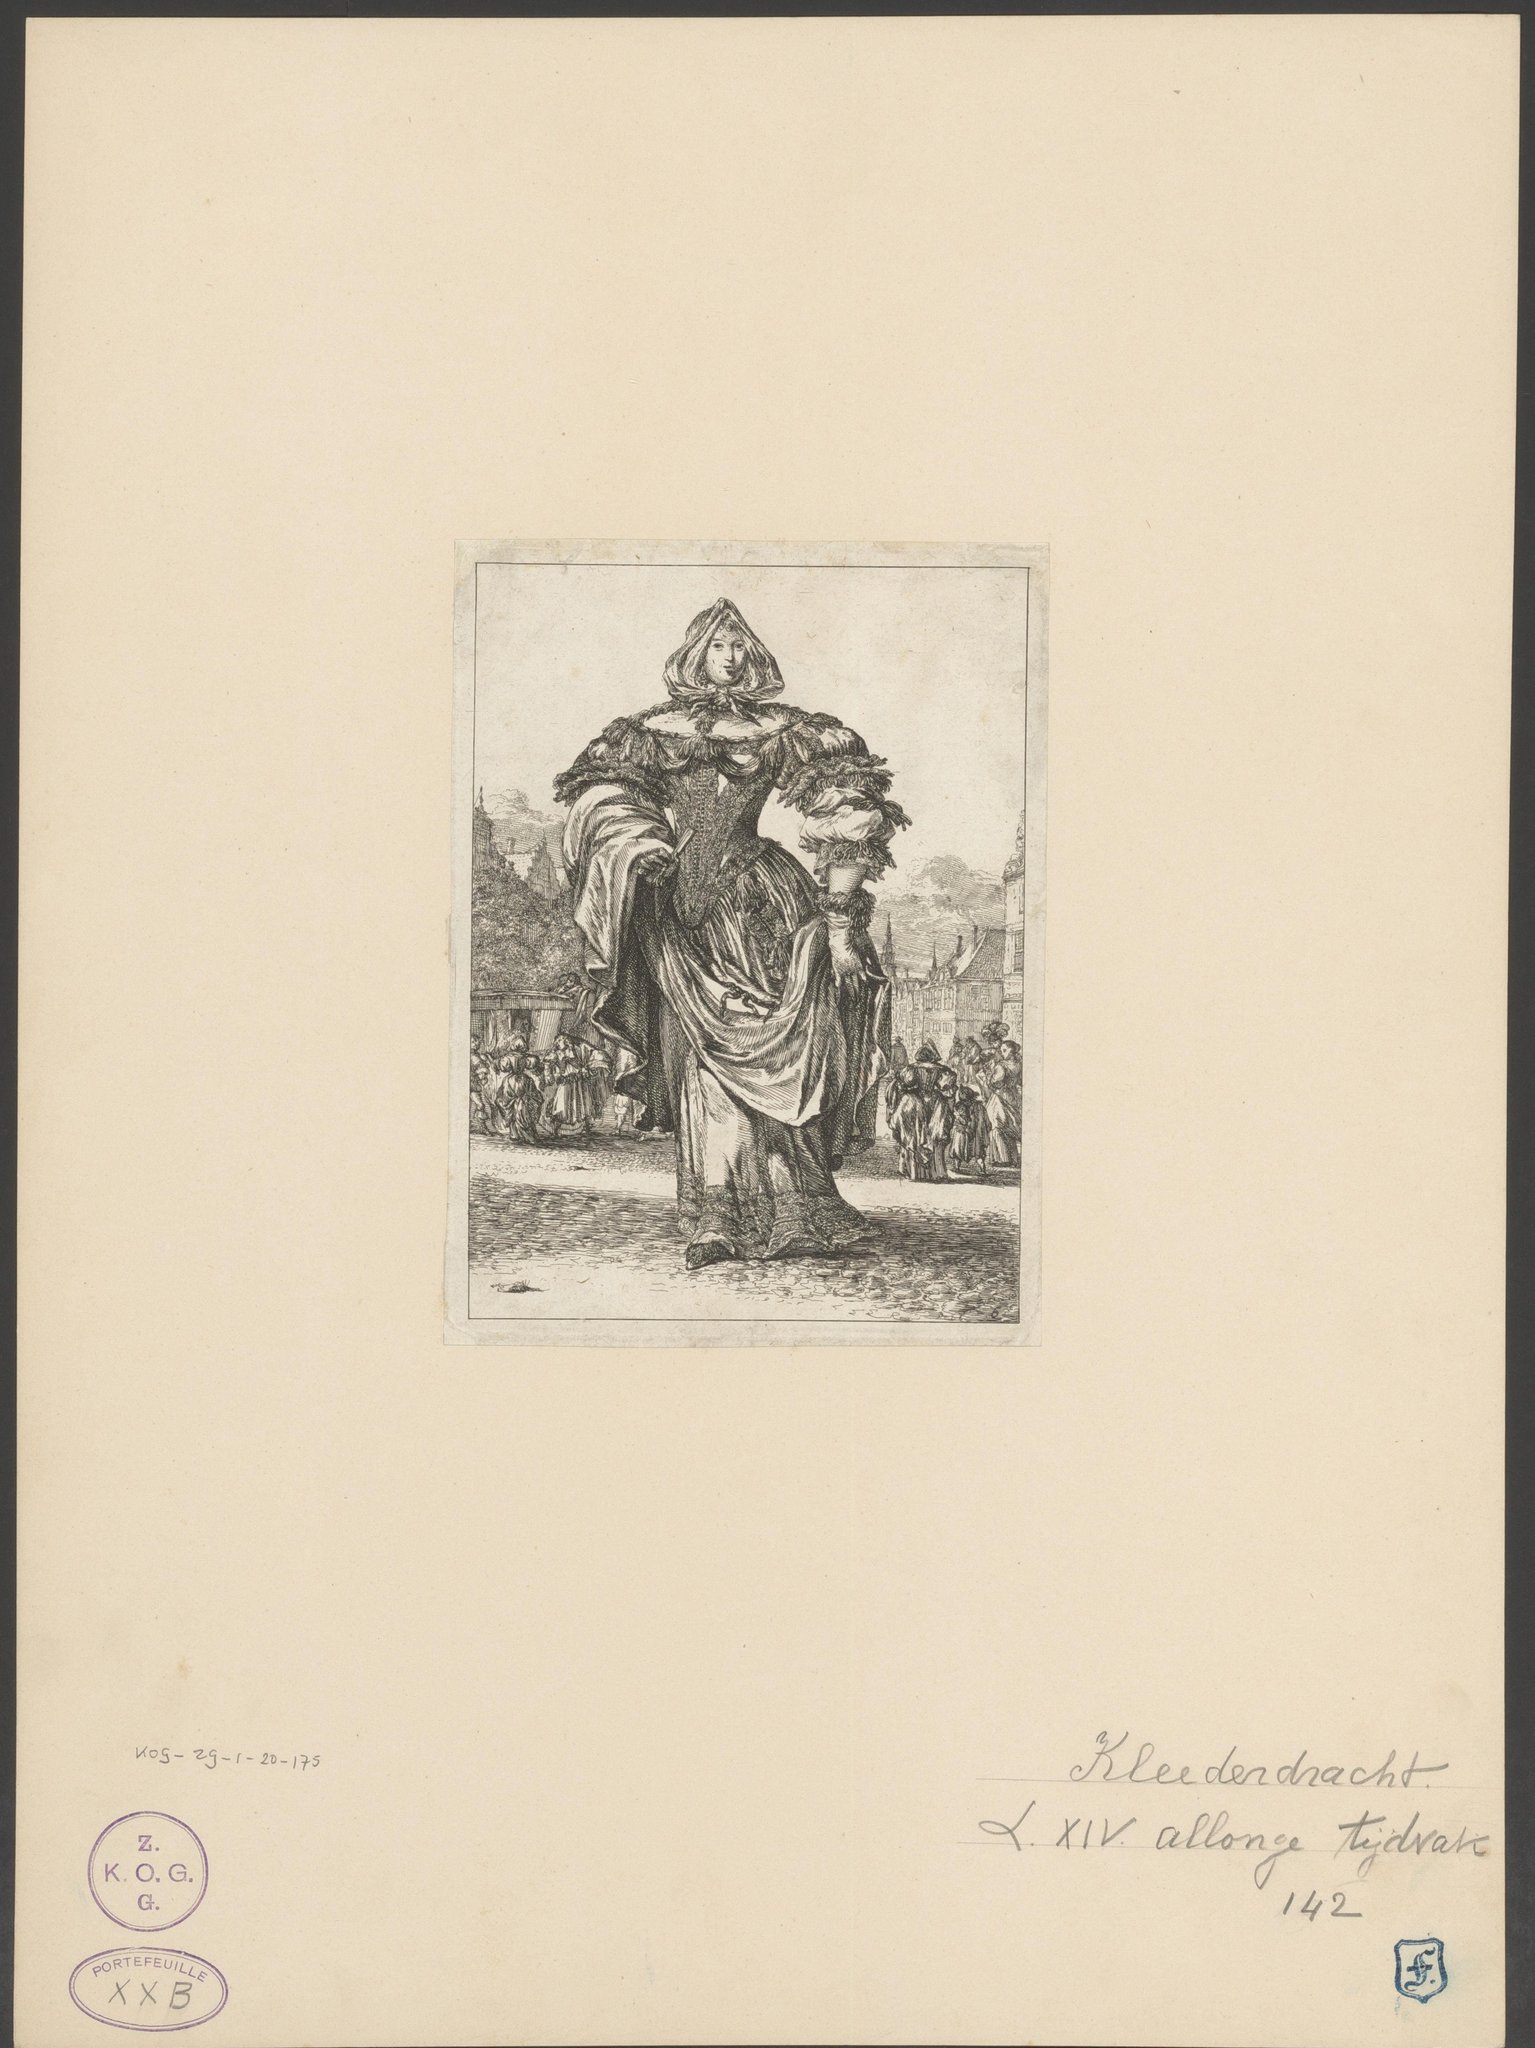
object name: print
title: Vrouw in japon met lintversiering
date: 1662-1702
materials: paper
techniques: etching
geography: amsterdam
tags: gloves, mittens (short gloves) (+ women's clothes), head-gear: cap (+ women's clothes), fashion plates, dress, gown (+ women's clothes), fan (+ women's clothes)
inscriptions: collector's mark: Lugt 963, collector's mark: Lugt 963, collector's mark: Lugt 1641, stamp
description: Vrouw gekleed in een japon met veel lintversiering langs de lage hals en de mouwen. Met de linkerhand houdt ze haar bovenrok op, in de rechterhand een dichtgeklapte waaier. Op het hoofd een wijde muts. Stadsplein met links een koets en figuren op de achtergrond. Onderwerpsrubrieken binnen de Atlas Zeden en Gewoonten: Zeden en Gewoonten in Engeren Zin, De Kleeding, Kleederdrachten (tijdvakken), Lodewijk XIV (1650 – 1720). Het allonge tijdvak).